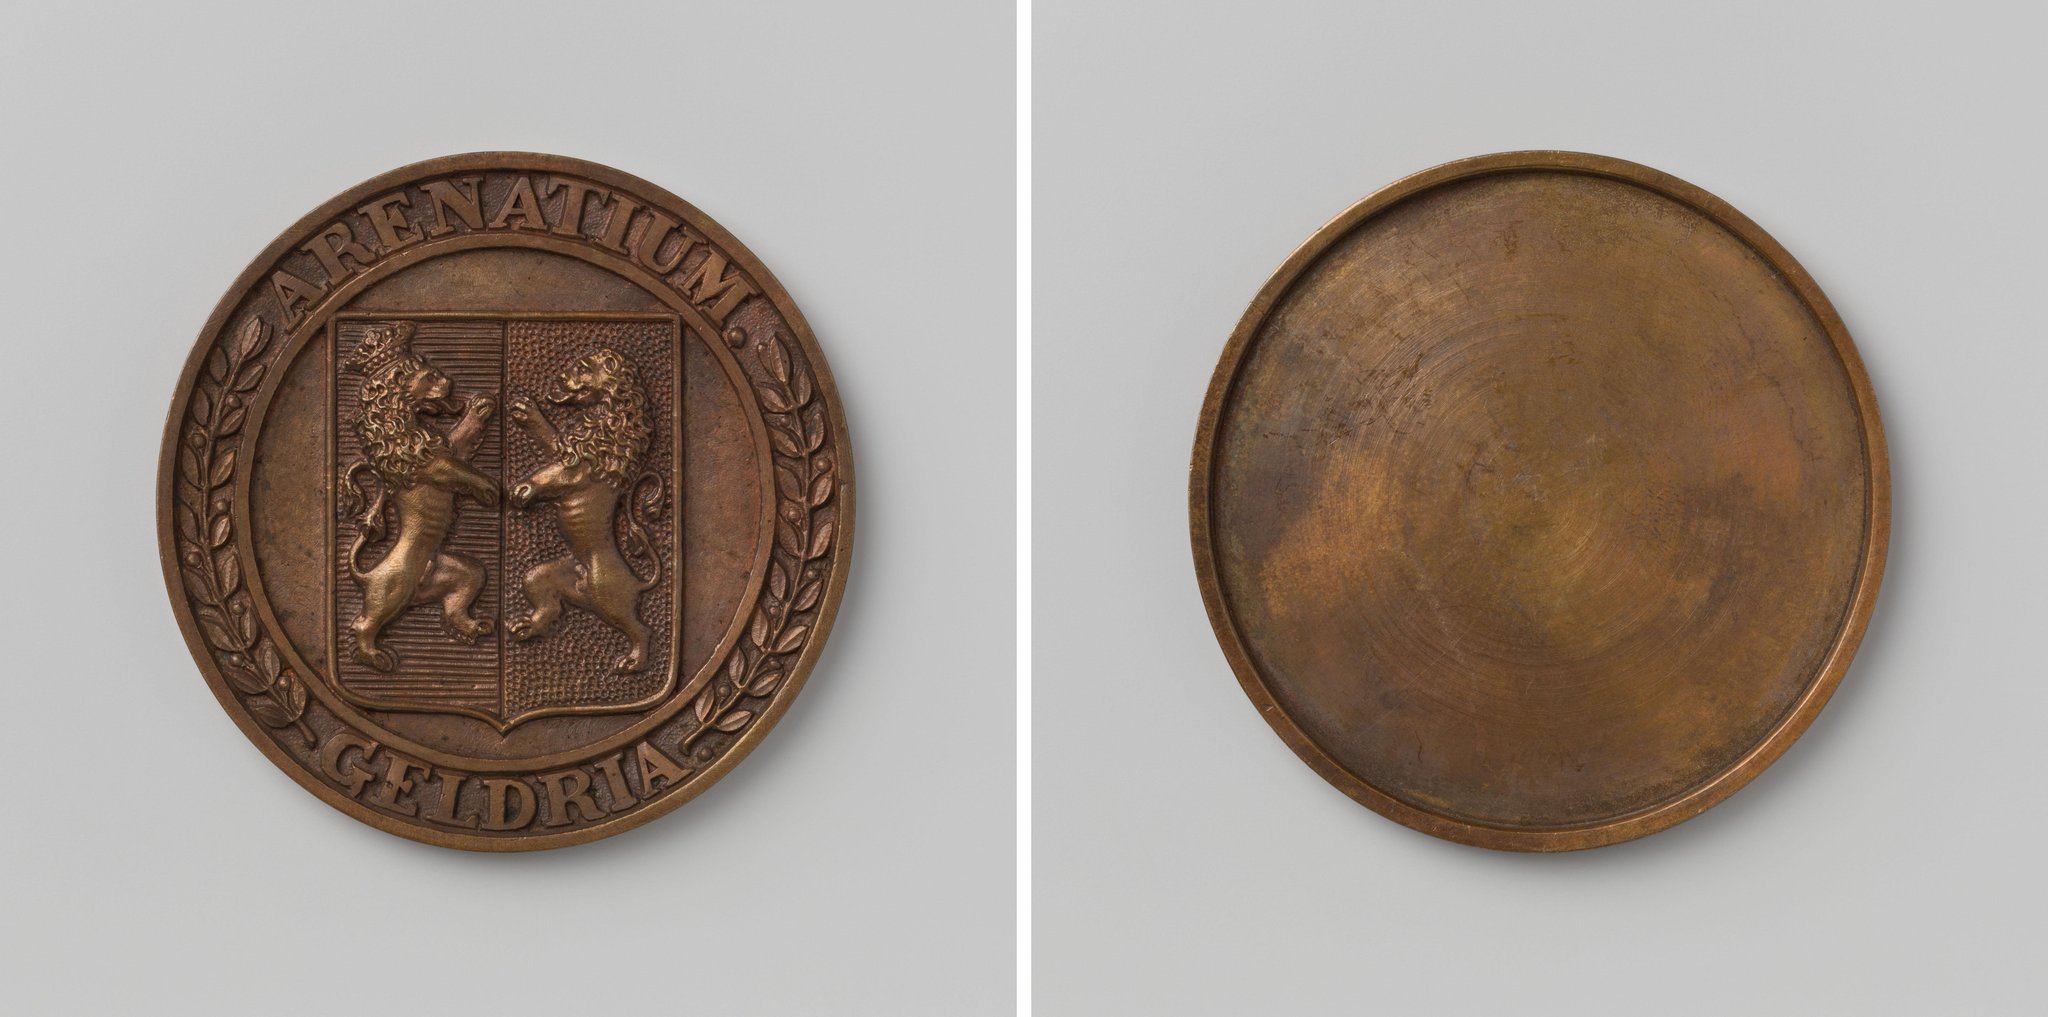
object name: medal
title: Arnhem, provincie Gelderland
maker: Anonymous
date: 1815-1830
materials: bronze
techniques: striking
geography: netherlands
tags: arnhem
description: Eenzijdige bronzen penning. Voorzijde: wapenschild binnen omschrift, onderbroken door twee bladertakken. Keerzijde: blanco